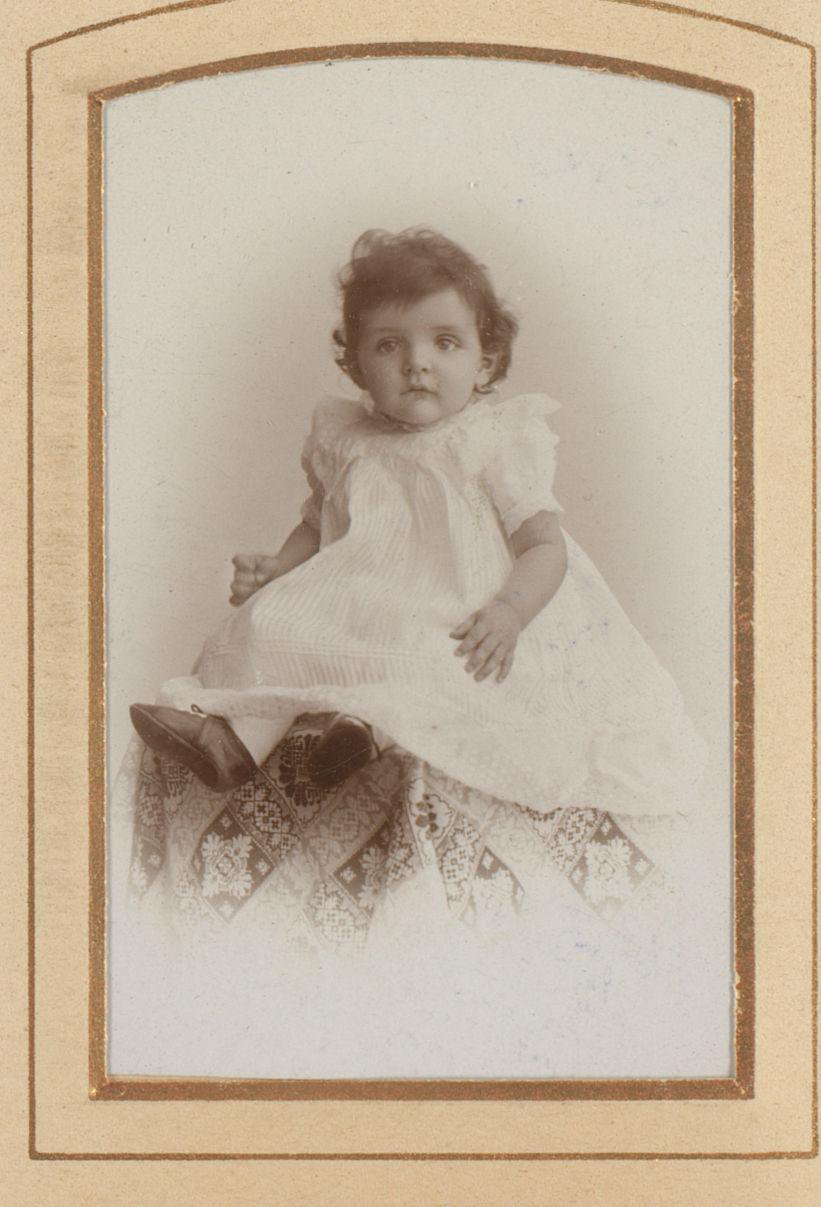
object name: album leaf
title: Portret van een zittend meisje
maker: Anonymous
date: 1890-1920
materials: cardboard, photographic support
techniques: collodion silver print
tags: girl (child between toddler and youth)